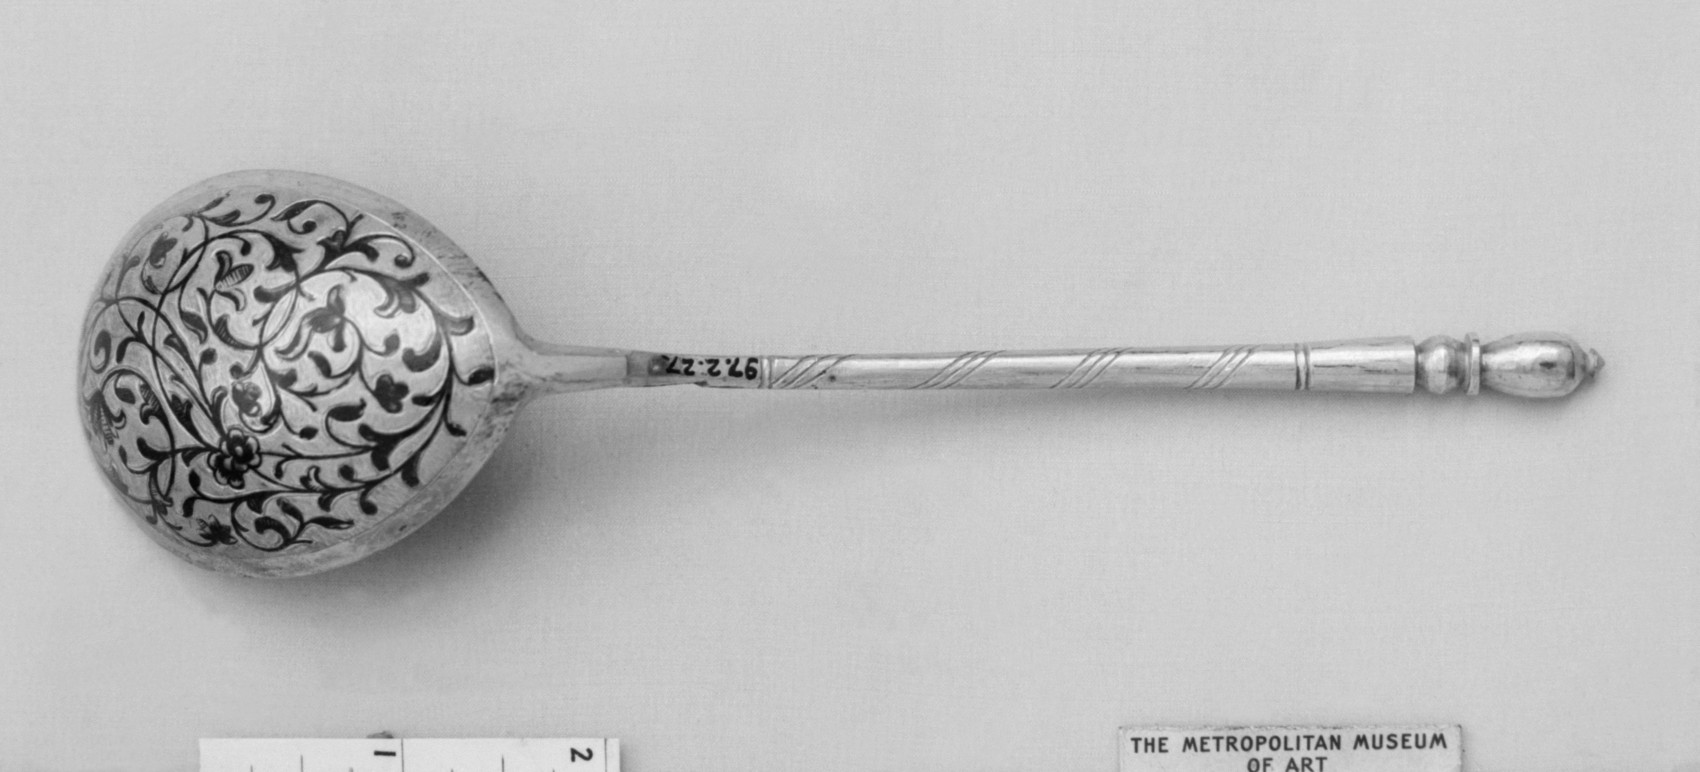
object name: spoon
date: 1767-1800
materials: gilt, silver